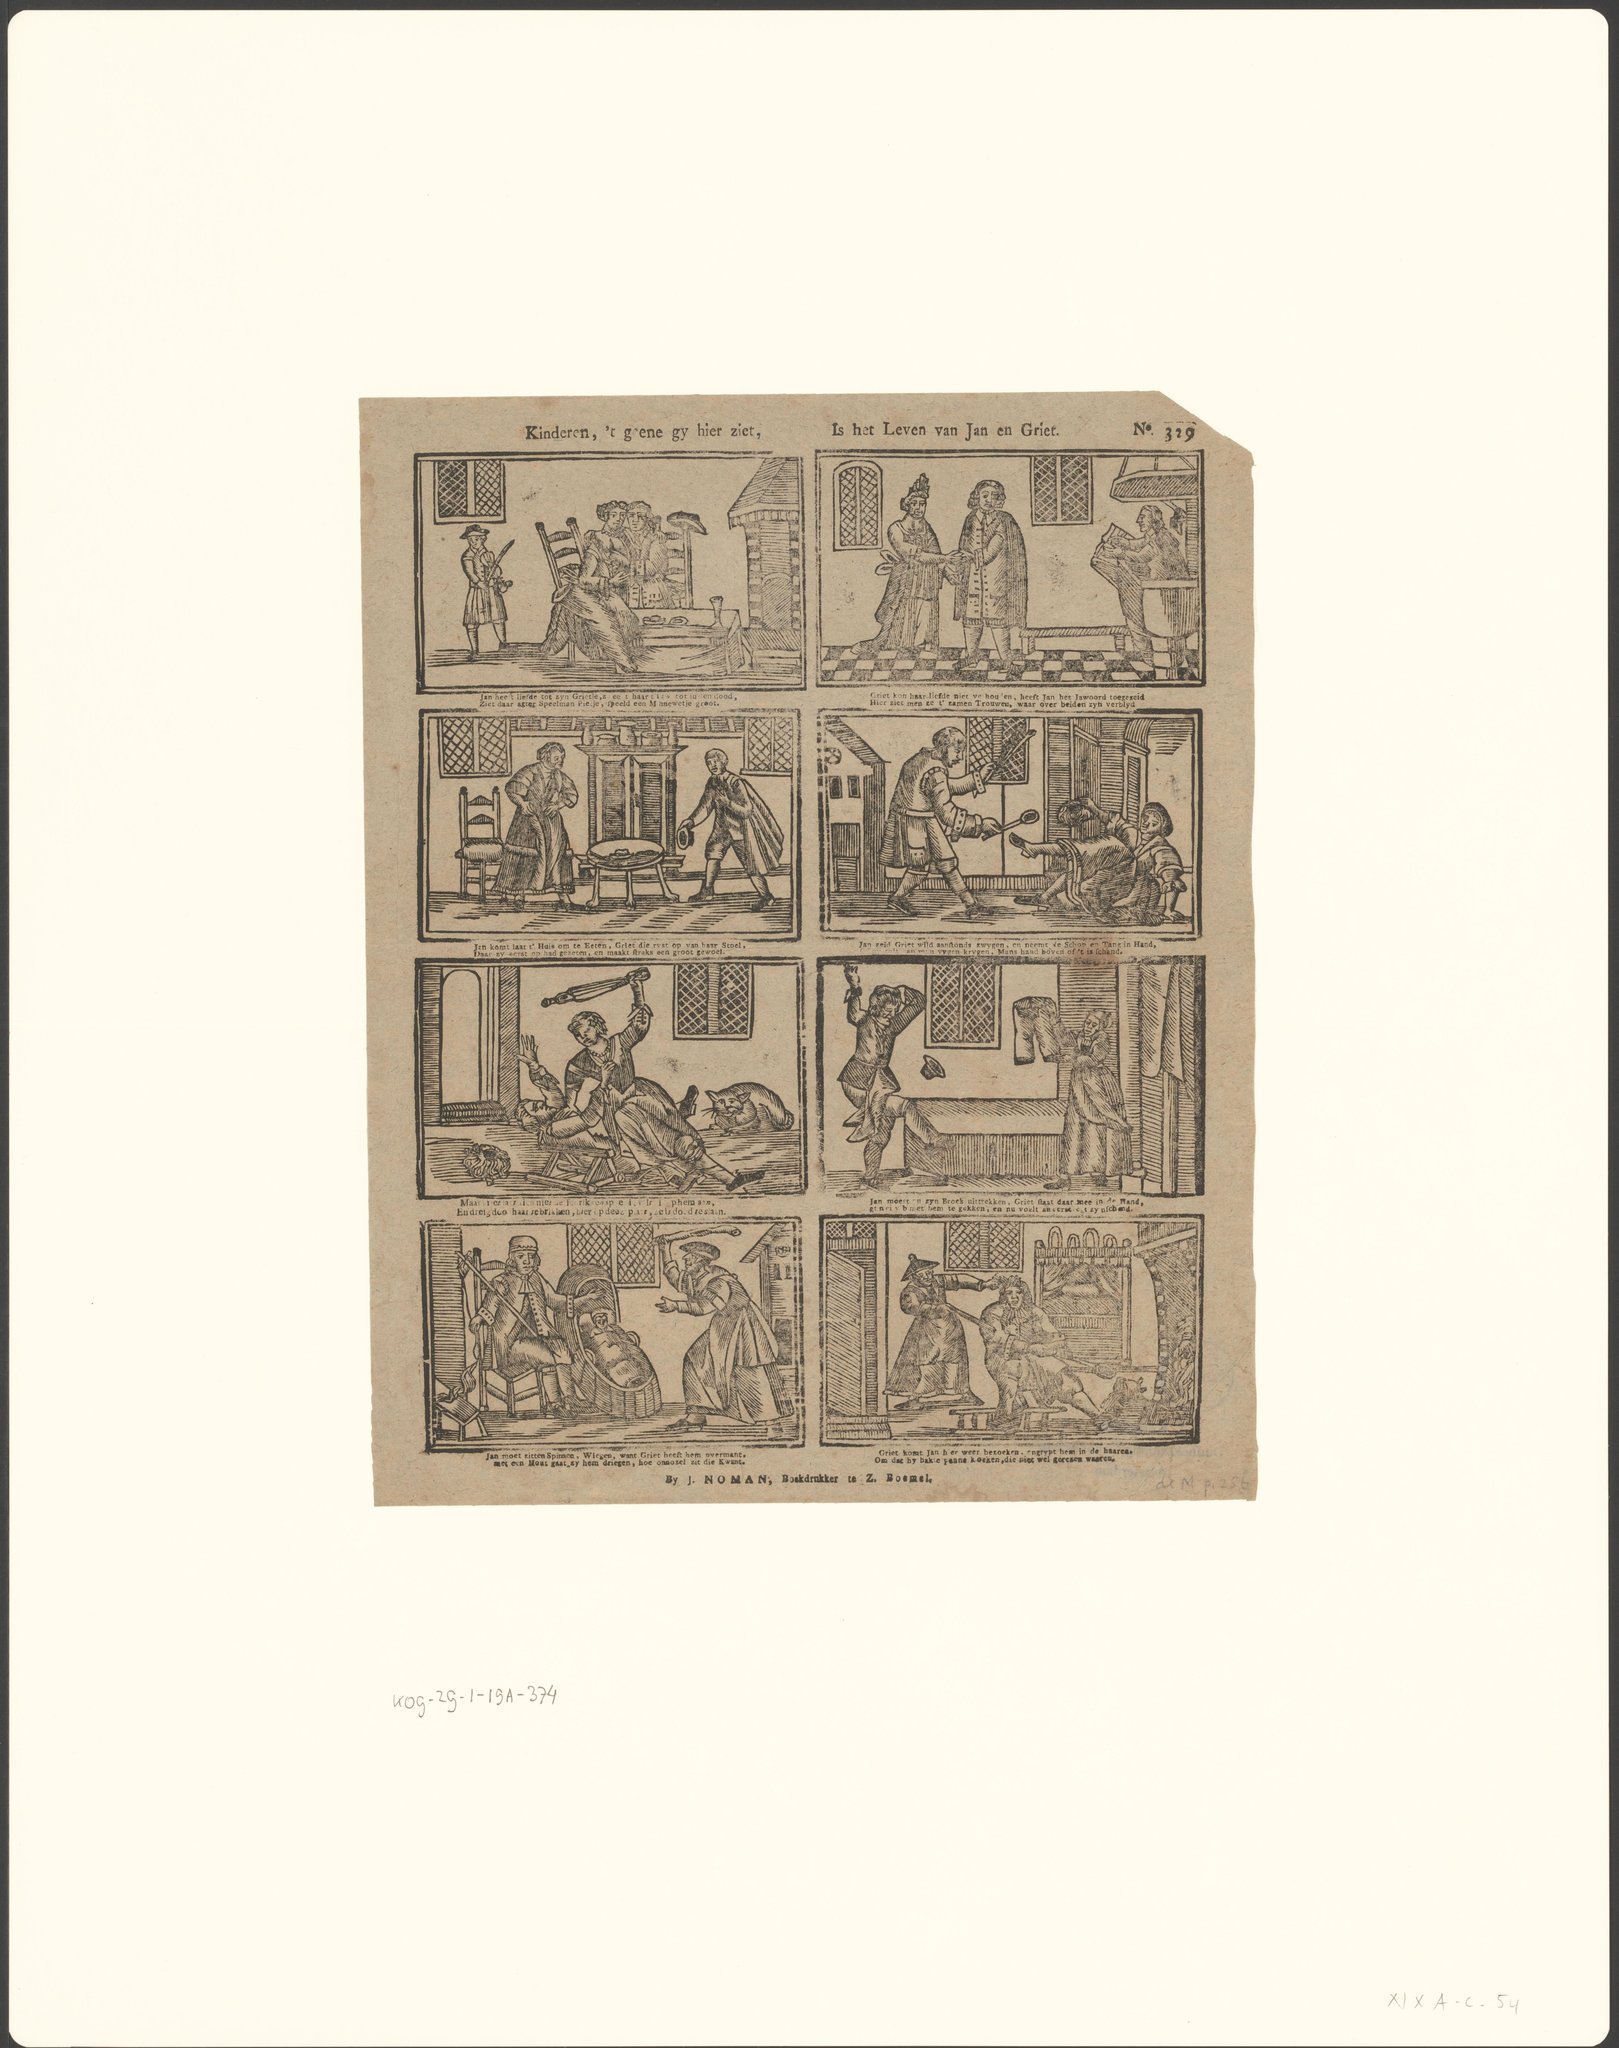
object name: popular print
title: Leven van Jan de Wasser en Griet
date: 1806-1830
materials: paper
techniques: letterpress printing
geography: zaltbommel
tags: hen-pecked husband, 'betty', 'molly' (man who engages in women's work)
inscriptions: stamp: ‘Koninklijk Oudheidkundig Genootschap Amsterdam’, collector's mark: Lugt 1641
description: Blad met acht voorstellingen uit het leven van Jan, een man die van zijn vrouw Griet, die de broek aan heeft, al het huishoudelijk werk moet doen. Een variant op zowel Jan de Wasser als op de strijd om de broek. Onder elke afbeelding een tweeregelig vers. Genummerd rechtsboven: No. 329. Onderwerpsrubrieken binnen de Atlas Zeden en Gewoonten: Zeden en Gewoonten in Engeren Zin, Des menschen beging, midden en einde, Kinderleven – Kinderspel en Kinderprenten.